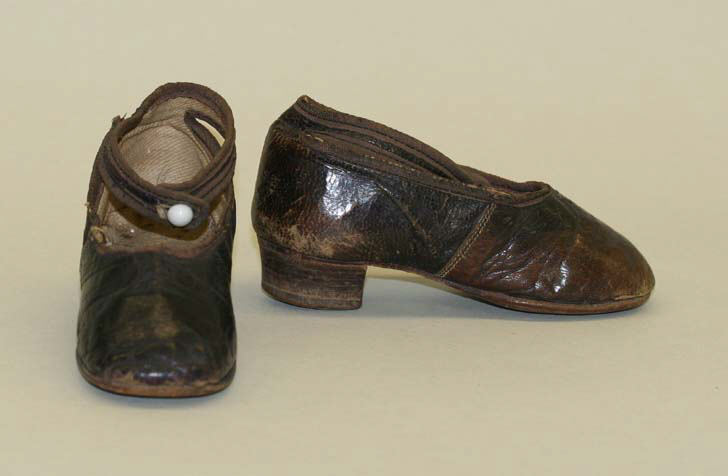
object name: slipper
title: Slippers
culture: american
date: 1868-1869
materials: leather